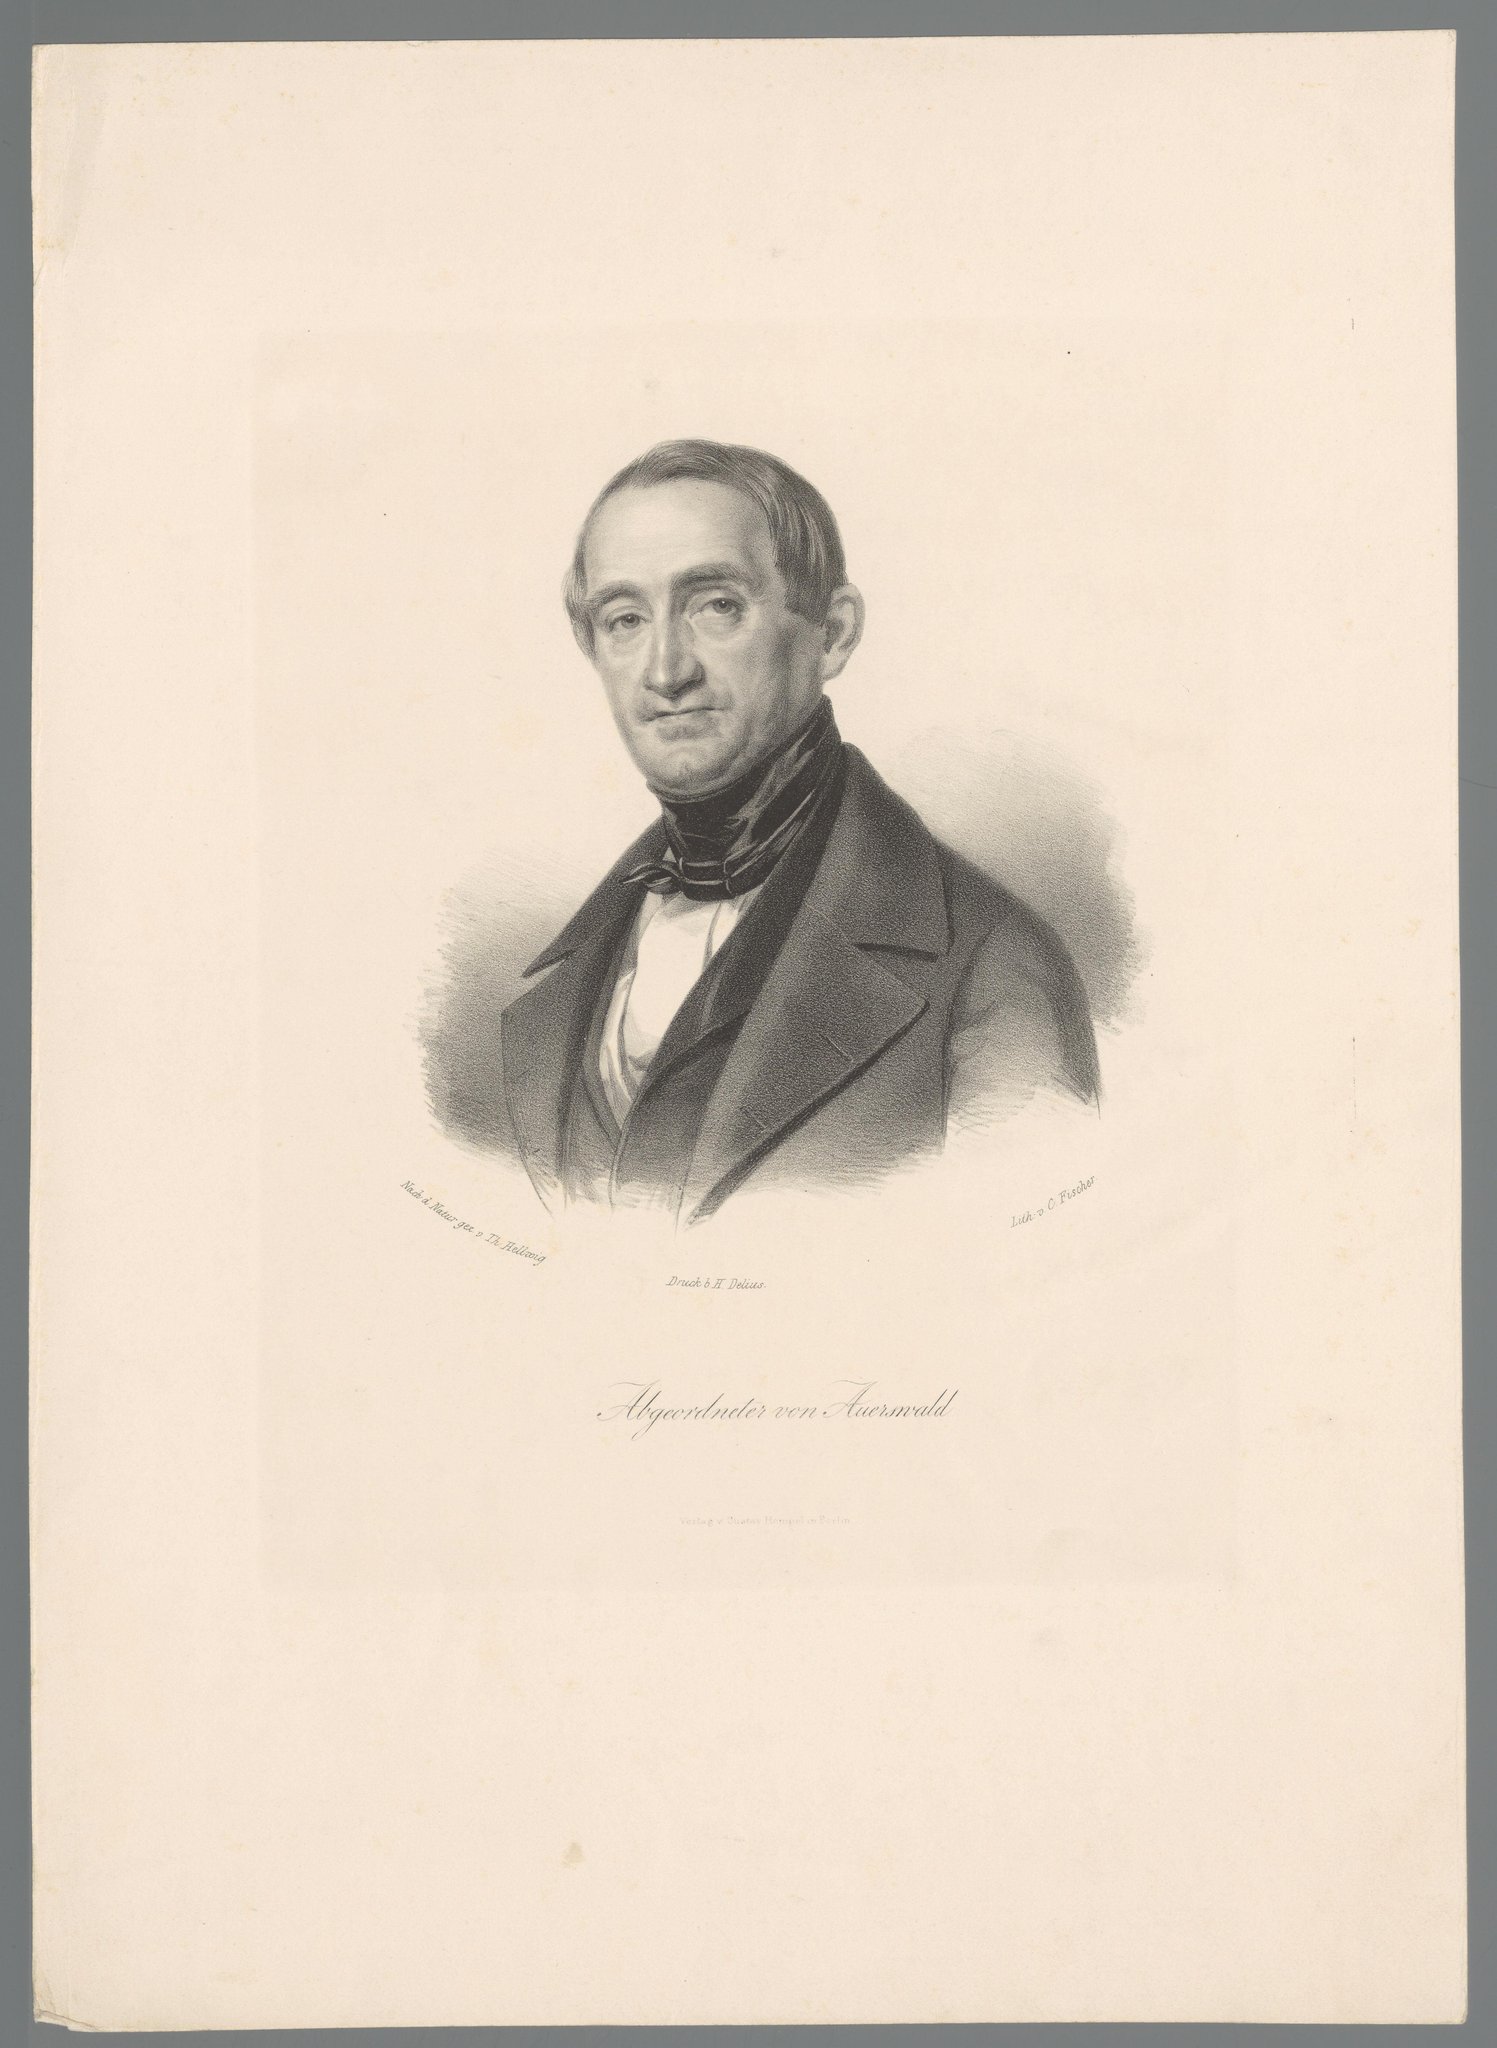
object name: print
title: Portret van Rudolf von Auerswald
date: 1846-1860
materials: paper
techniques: lithograph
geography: berlin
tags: berlin, politician, official; civil servant; functionary (in general), historical persons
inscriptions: collector's mark: Lugt 2228